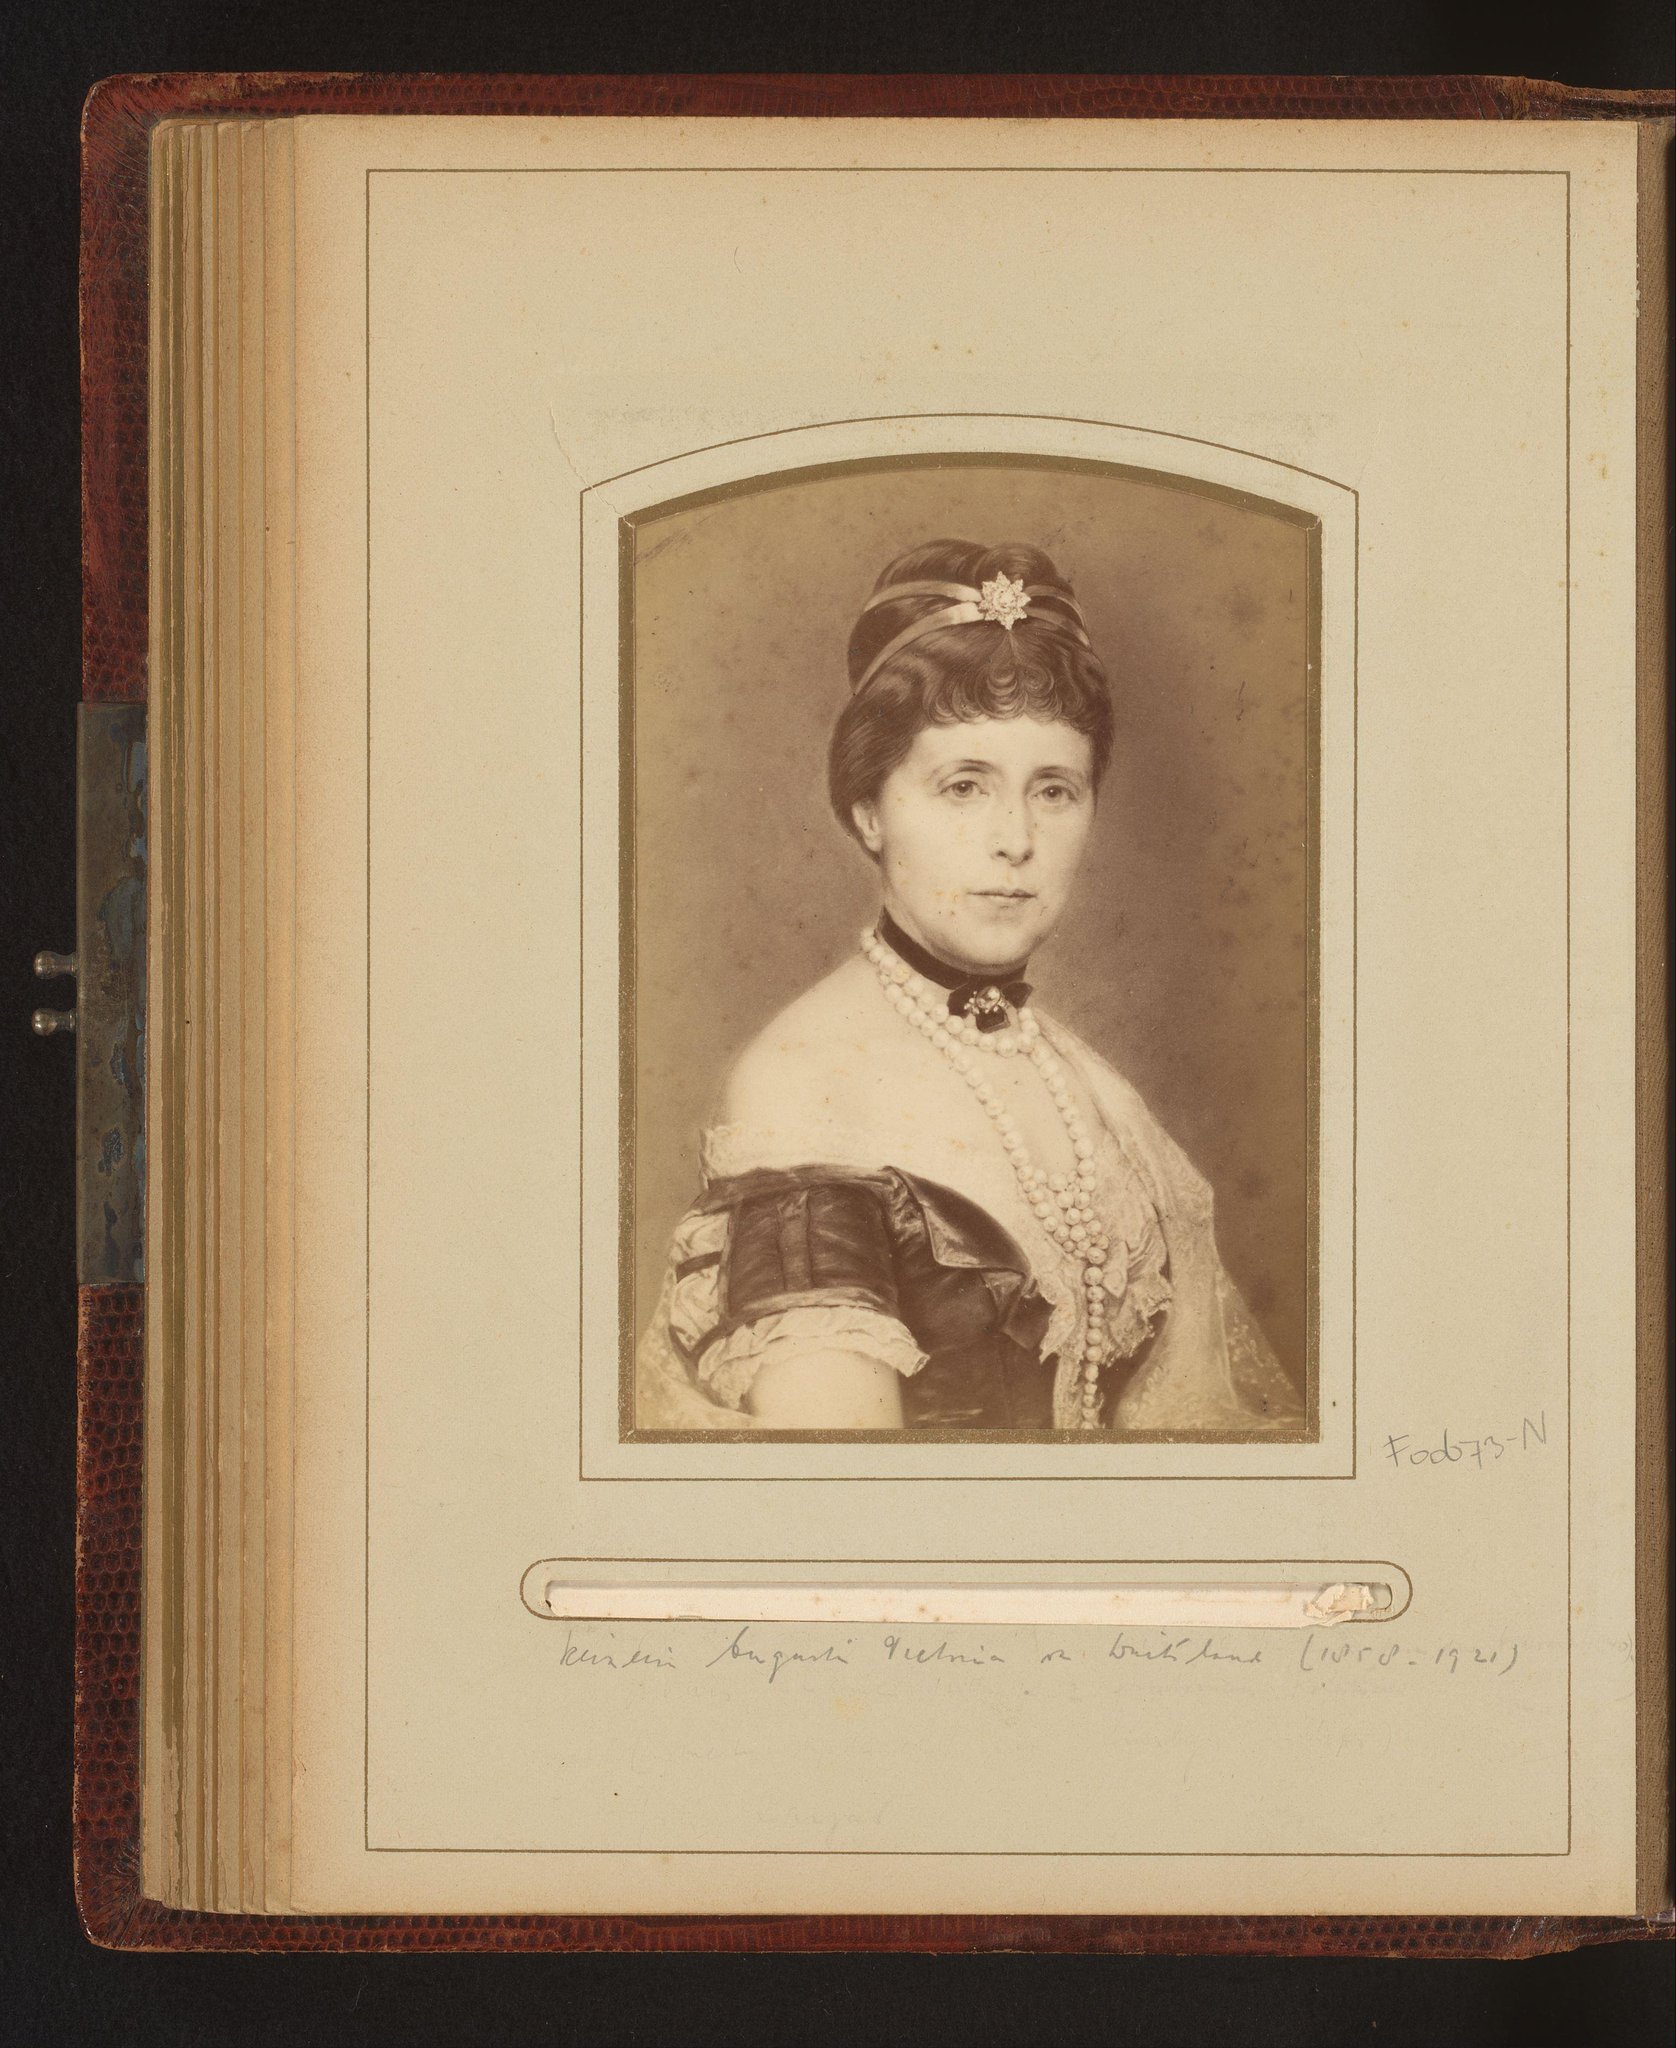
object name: reproduction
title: Fotoreproductie van een portret van Augusta Victoria van Duitsland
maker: f. jamrath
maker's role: fotograaf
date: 1888-1921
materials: cardboard, photographic support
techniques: albumen print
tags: augusta victoria (keizerin van duitsland), historical persons - bb - woman, emperor - bb - female ruler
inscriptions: annotation: ‘Keizerin Augusta Victoria van Duitsland (1858 - 1921)’, annotation: ‘Kaiserin von Deutschland/ Augusta Victoria van Sleeswijk Holstein/ geh 27/2 '81 met Wilhelm II/ Keizerin [15/6] '88’, inscription: ‘F. Jamrath & Sohn/ Hof-Photographen (...) Berlin S.W./ 14 Belle-Alliance-str. 14/ Früher Tauber-Str. 20.’